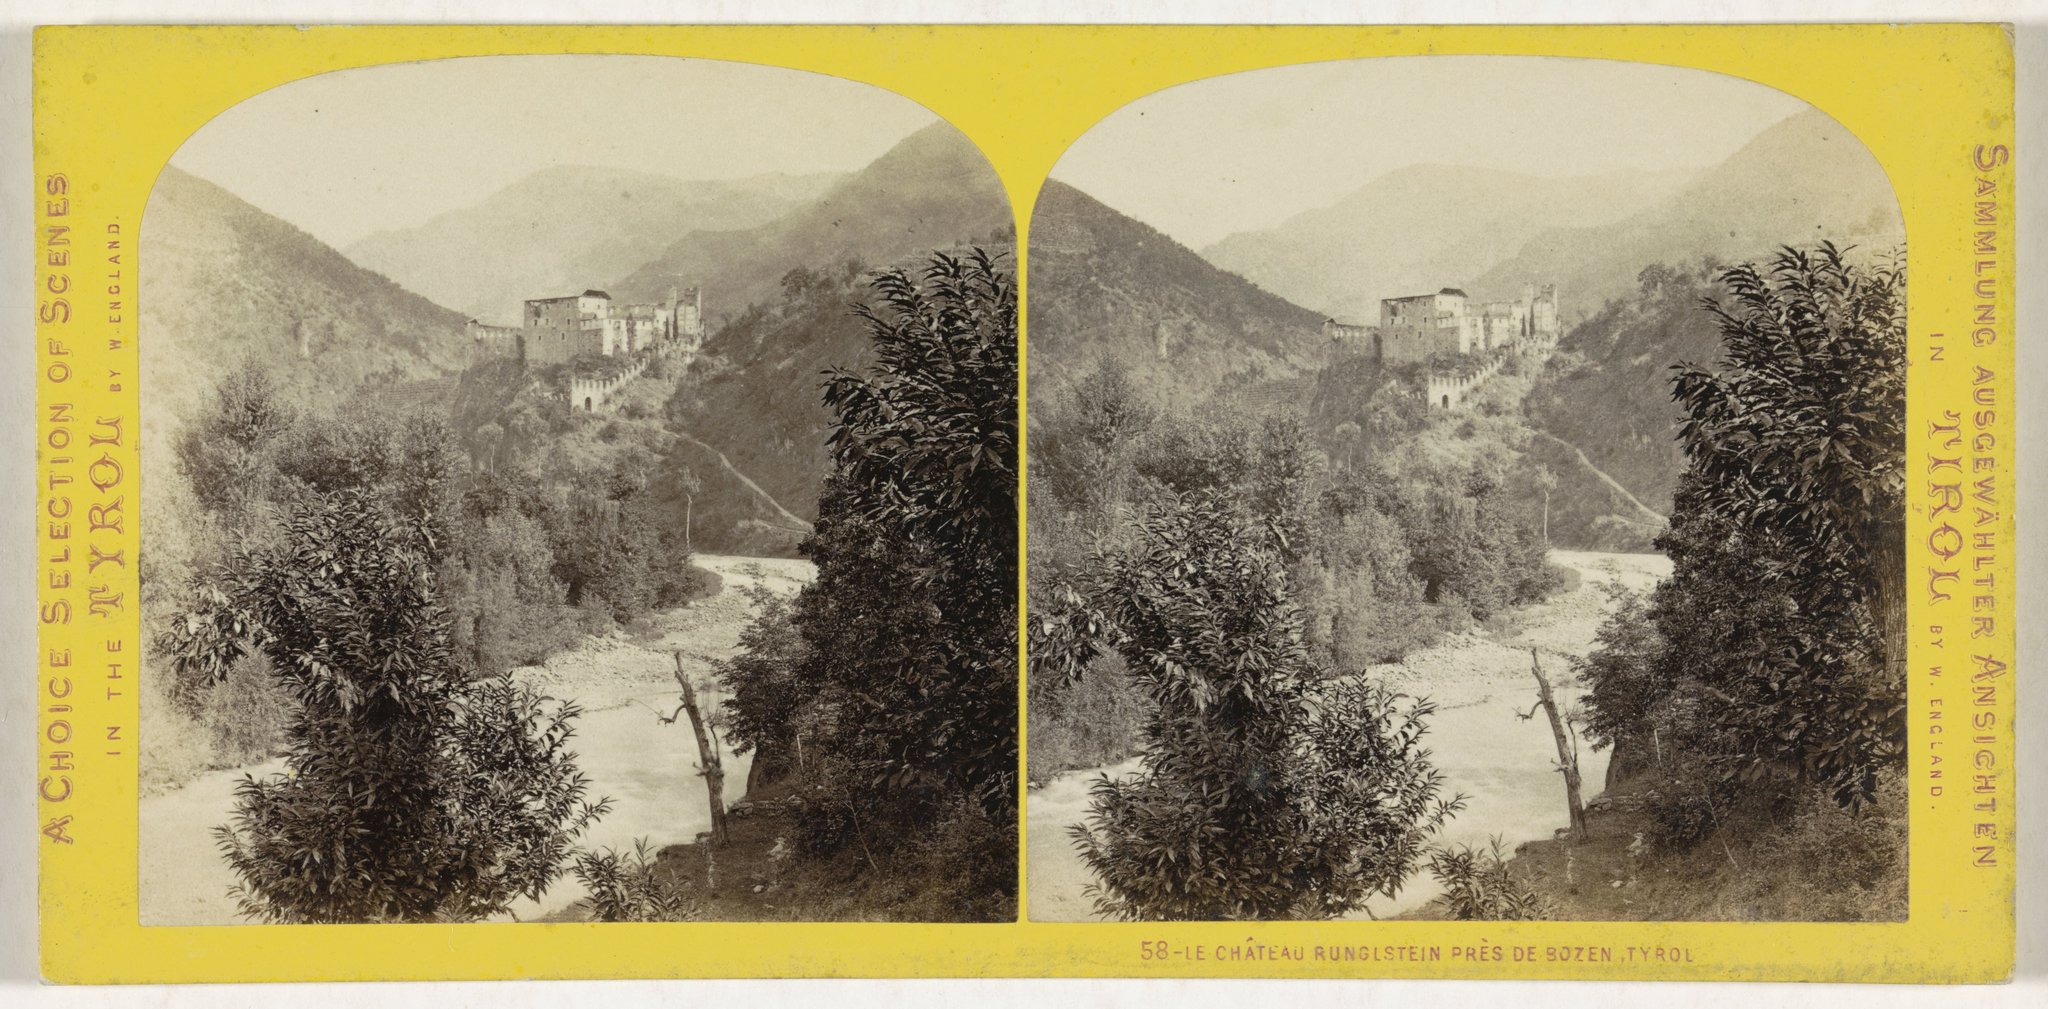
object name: stereograph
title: Le Château Runglstein près de Bozen, Tyrol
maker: william england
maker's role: fotograaf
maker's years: 1816-1896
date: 1863-1865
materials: cardboard, paper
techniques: albumen print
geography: bolzano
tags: castle, landscape with tower or castle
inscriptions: number: ‘58’